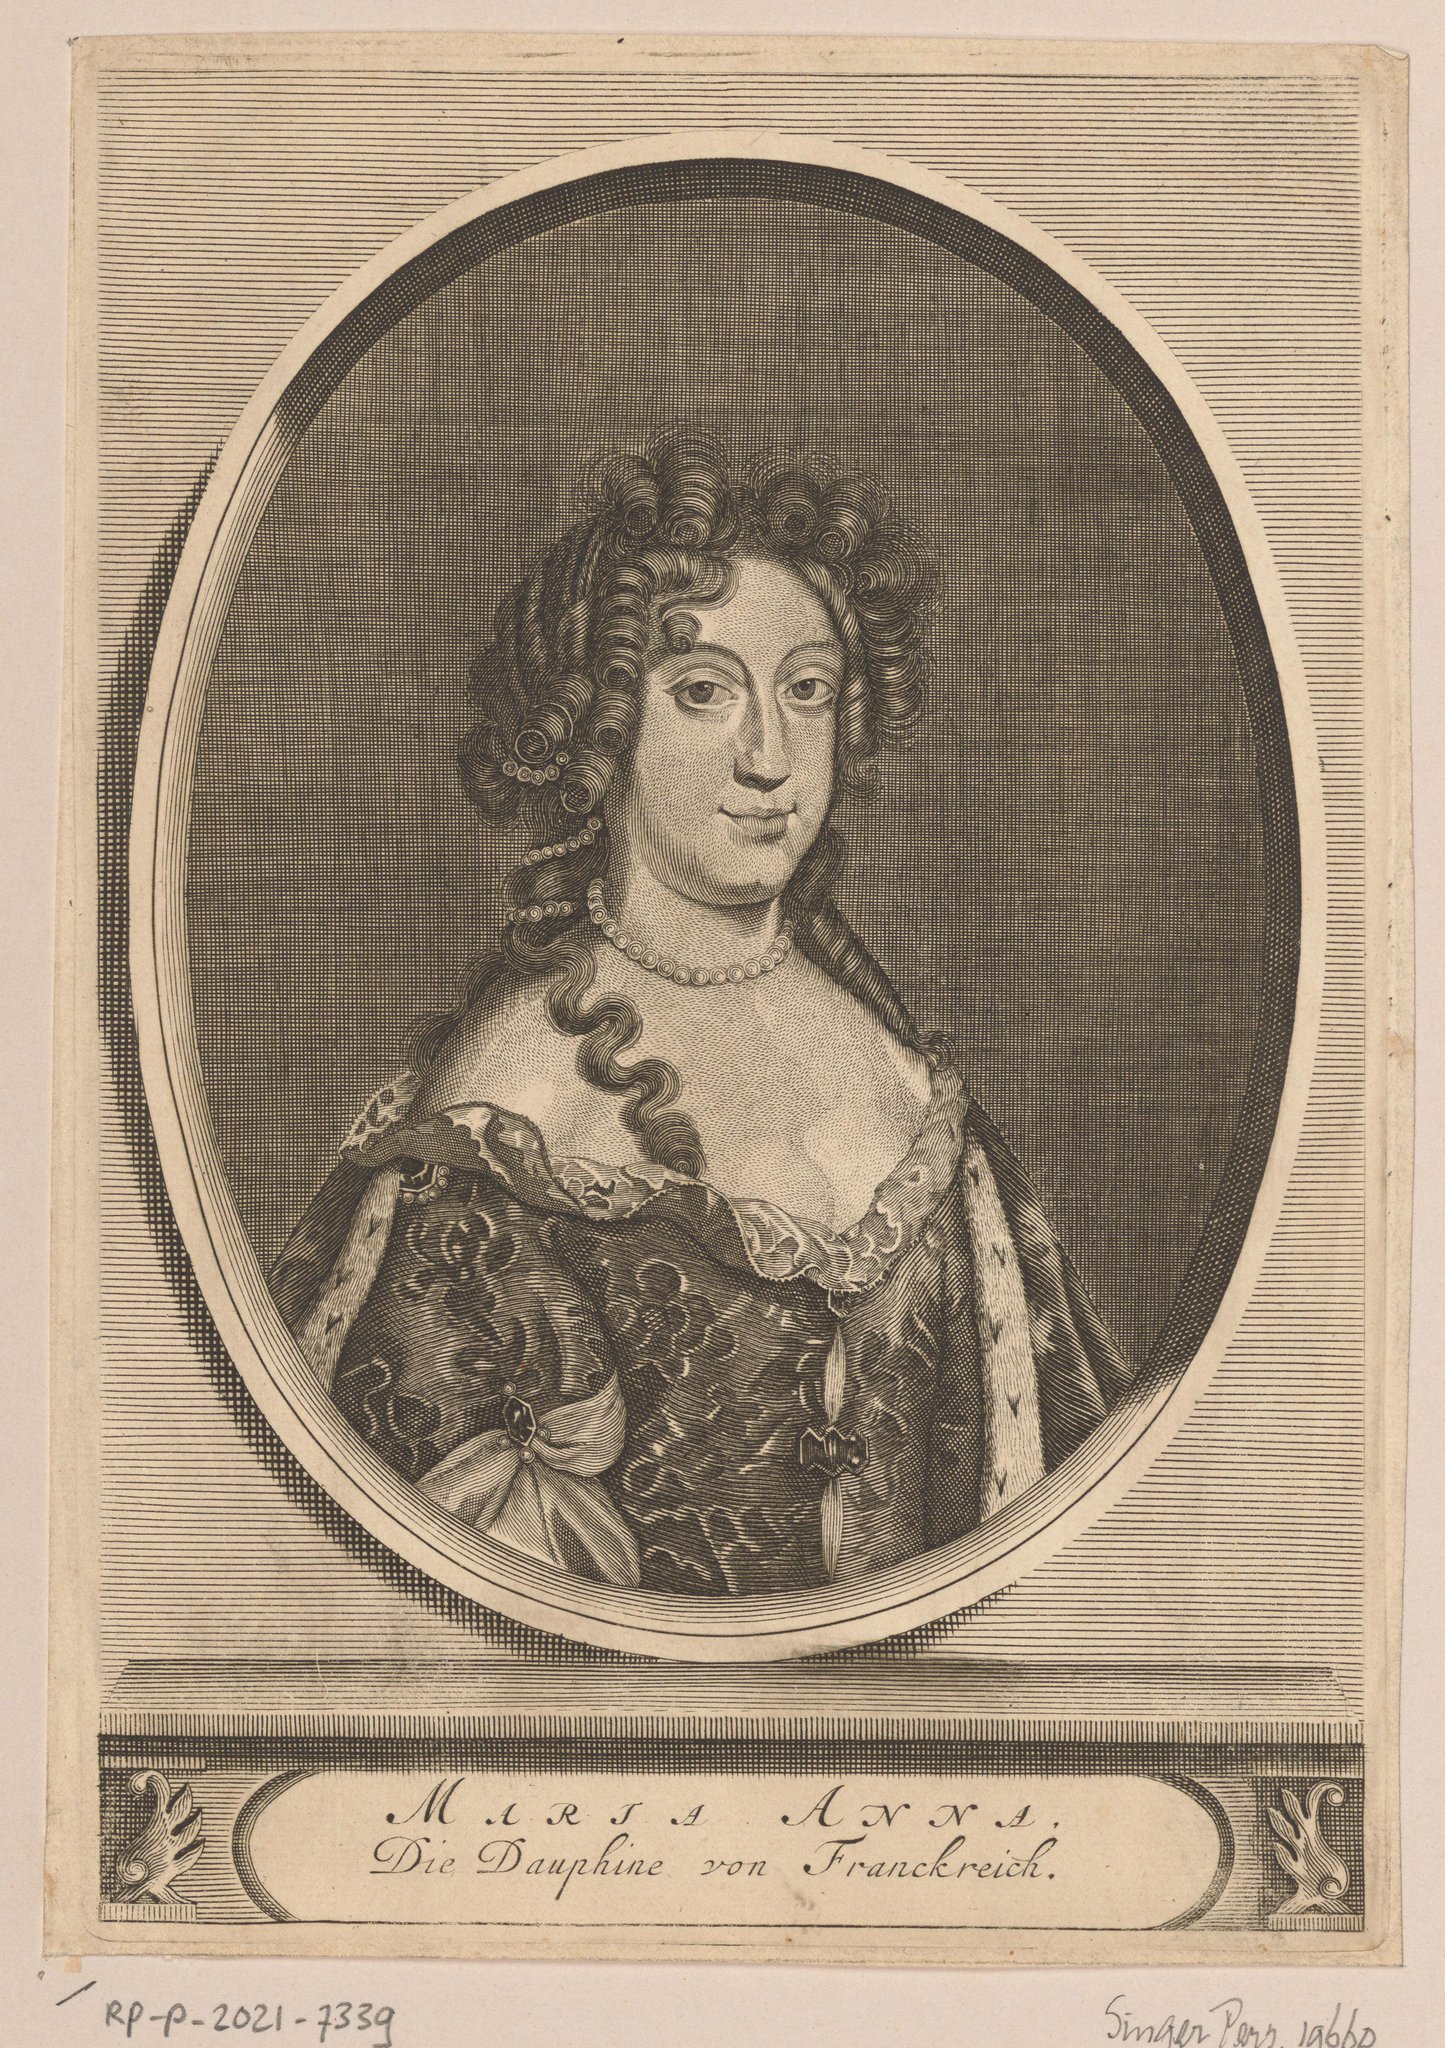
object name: print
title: Portret van Maria Anna Victoria van Beieren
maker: Anonymous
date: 1680-1690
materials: paper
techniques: engraving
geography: germany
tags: maria anna van beieren dauphine van frankrijk, historical persons - bb - woman, ornament ~ medallion, pearl; pearl necklace